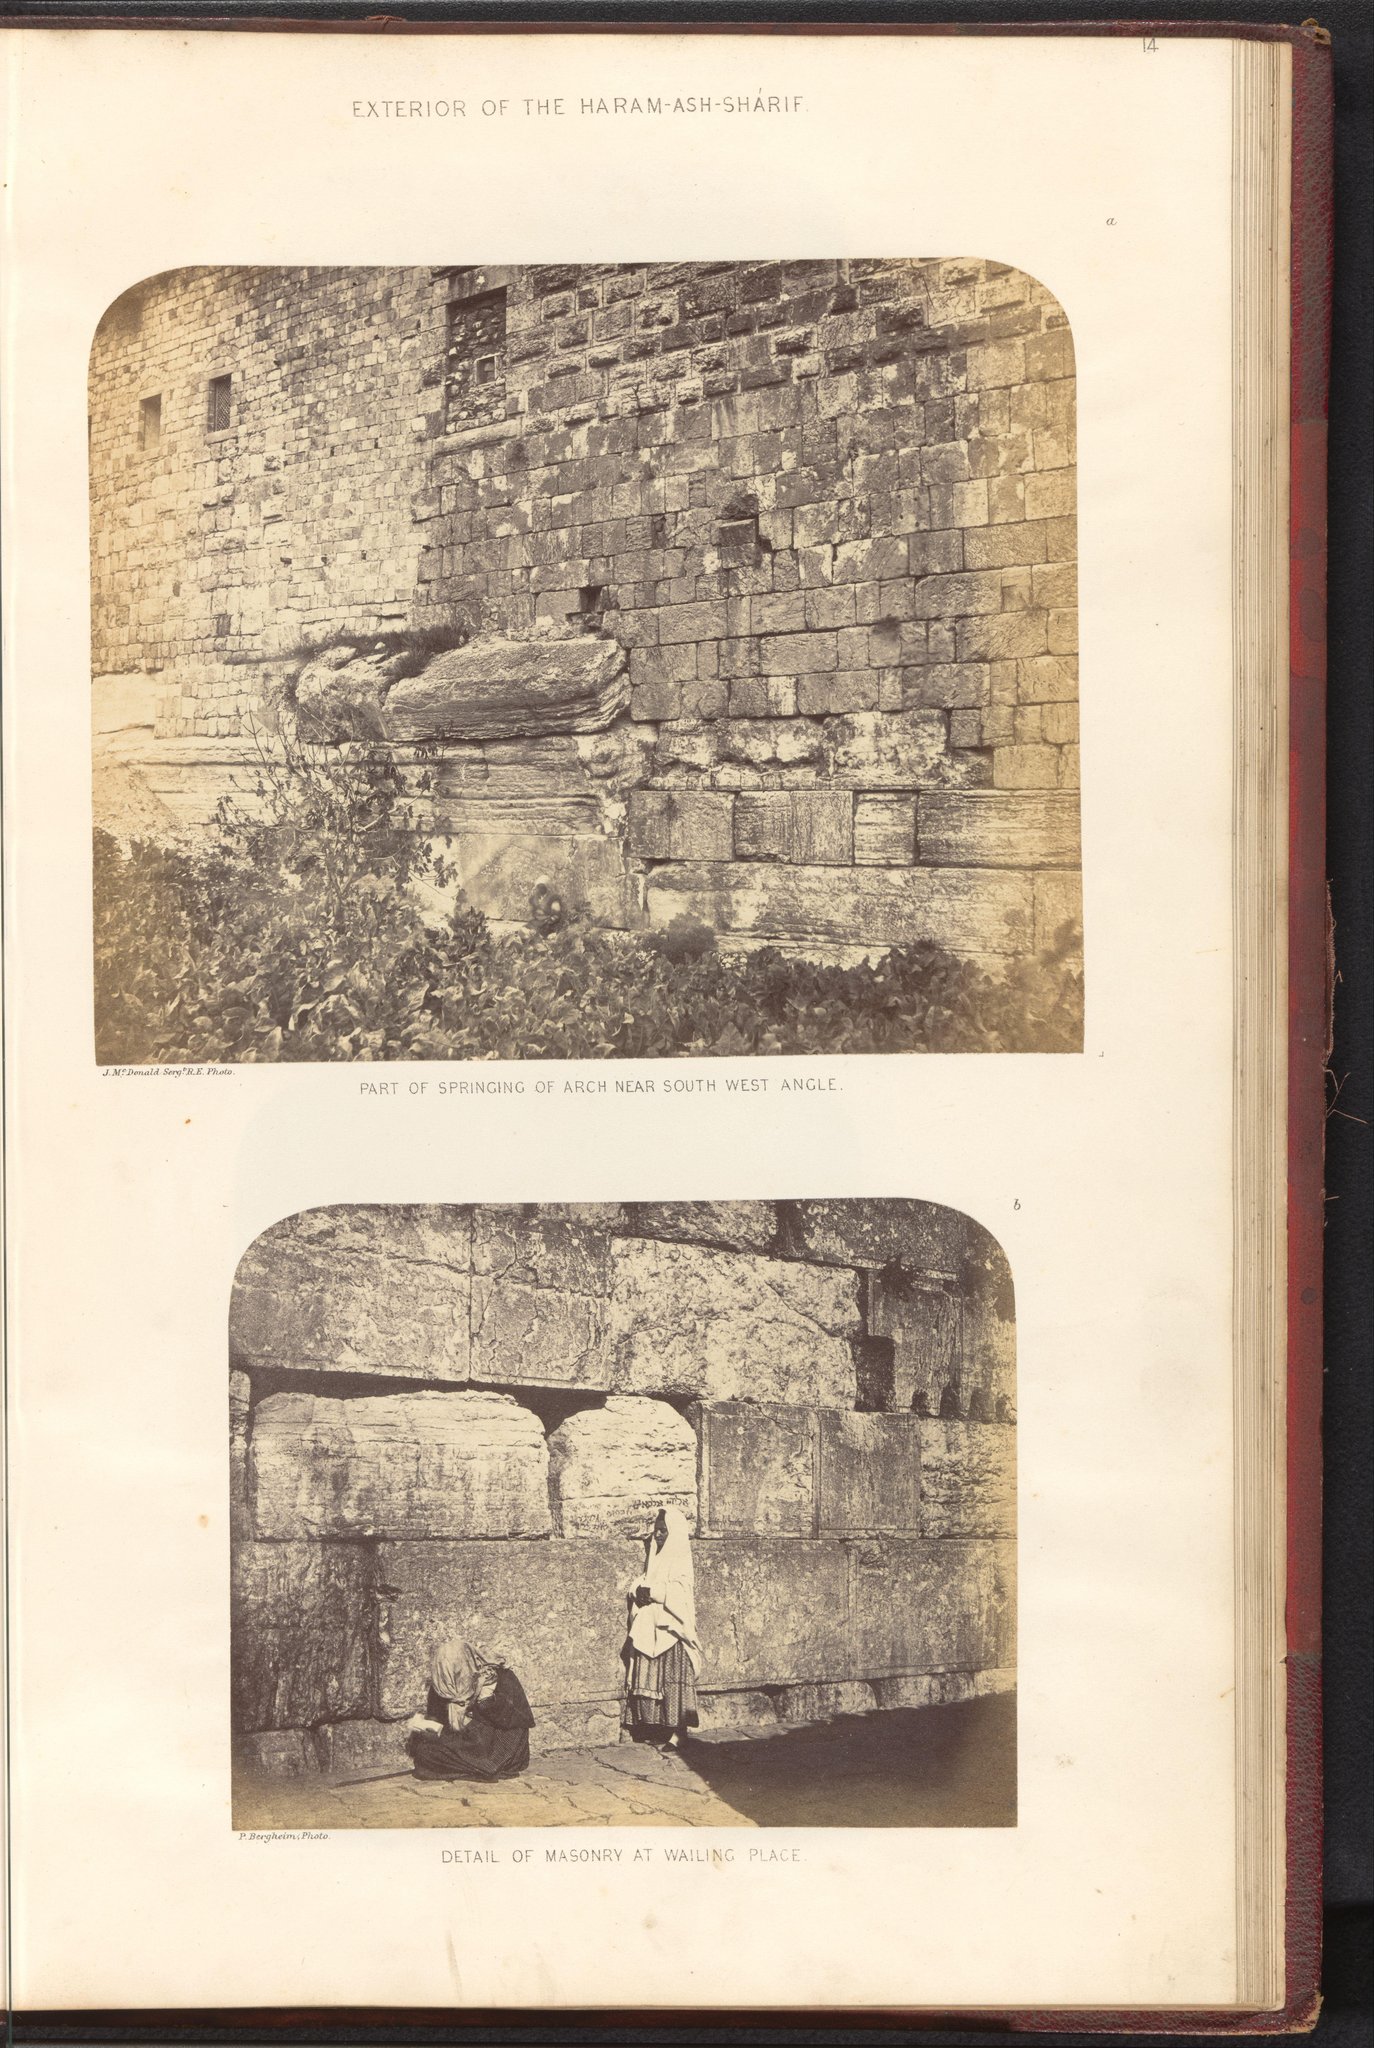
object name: page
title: Part of Springing or Arch near South West Angle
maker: james mcdonald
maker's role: fotograaf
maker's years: 1822-1885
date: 1860-1865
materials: paper, photographic support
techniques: albumen print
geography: tempelberg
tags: wailing wall ~ jewish religion, city-walls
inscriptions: inscription: ‘a’, inscription: ‘b’